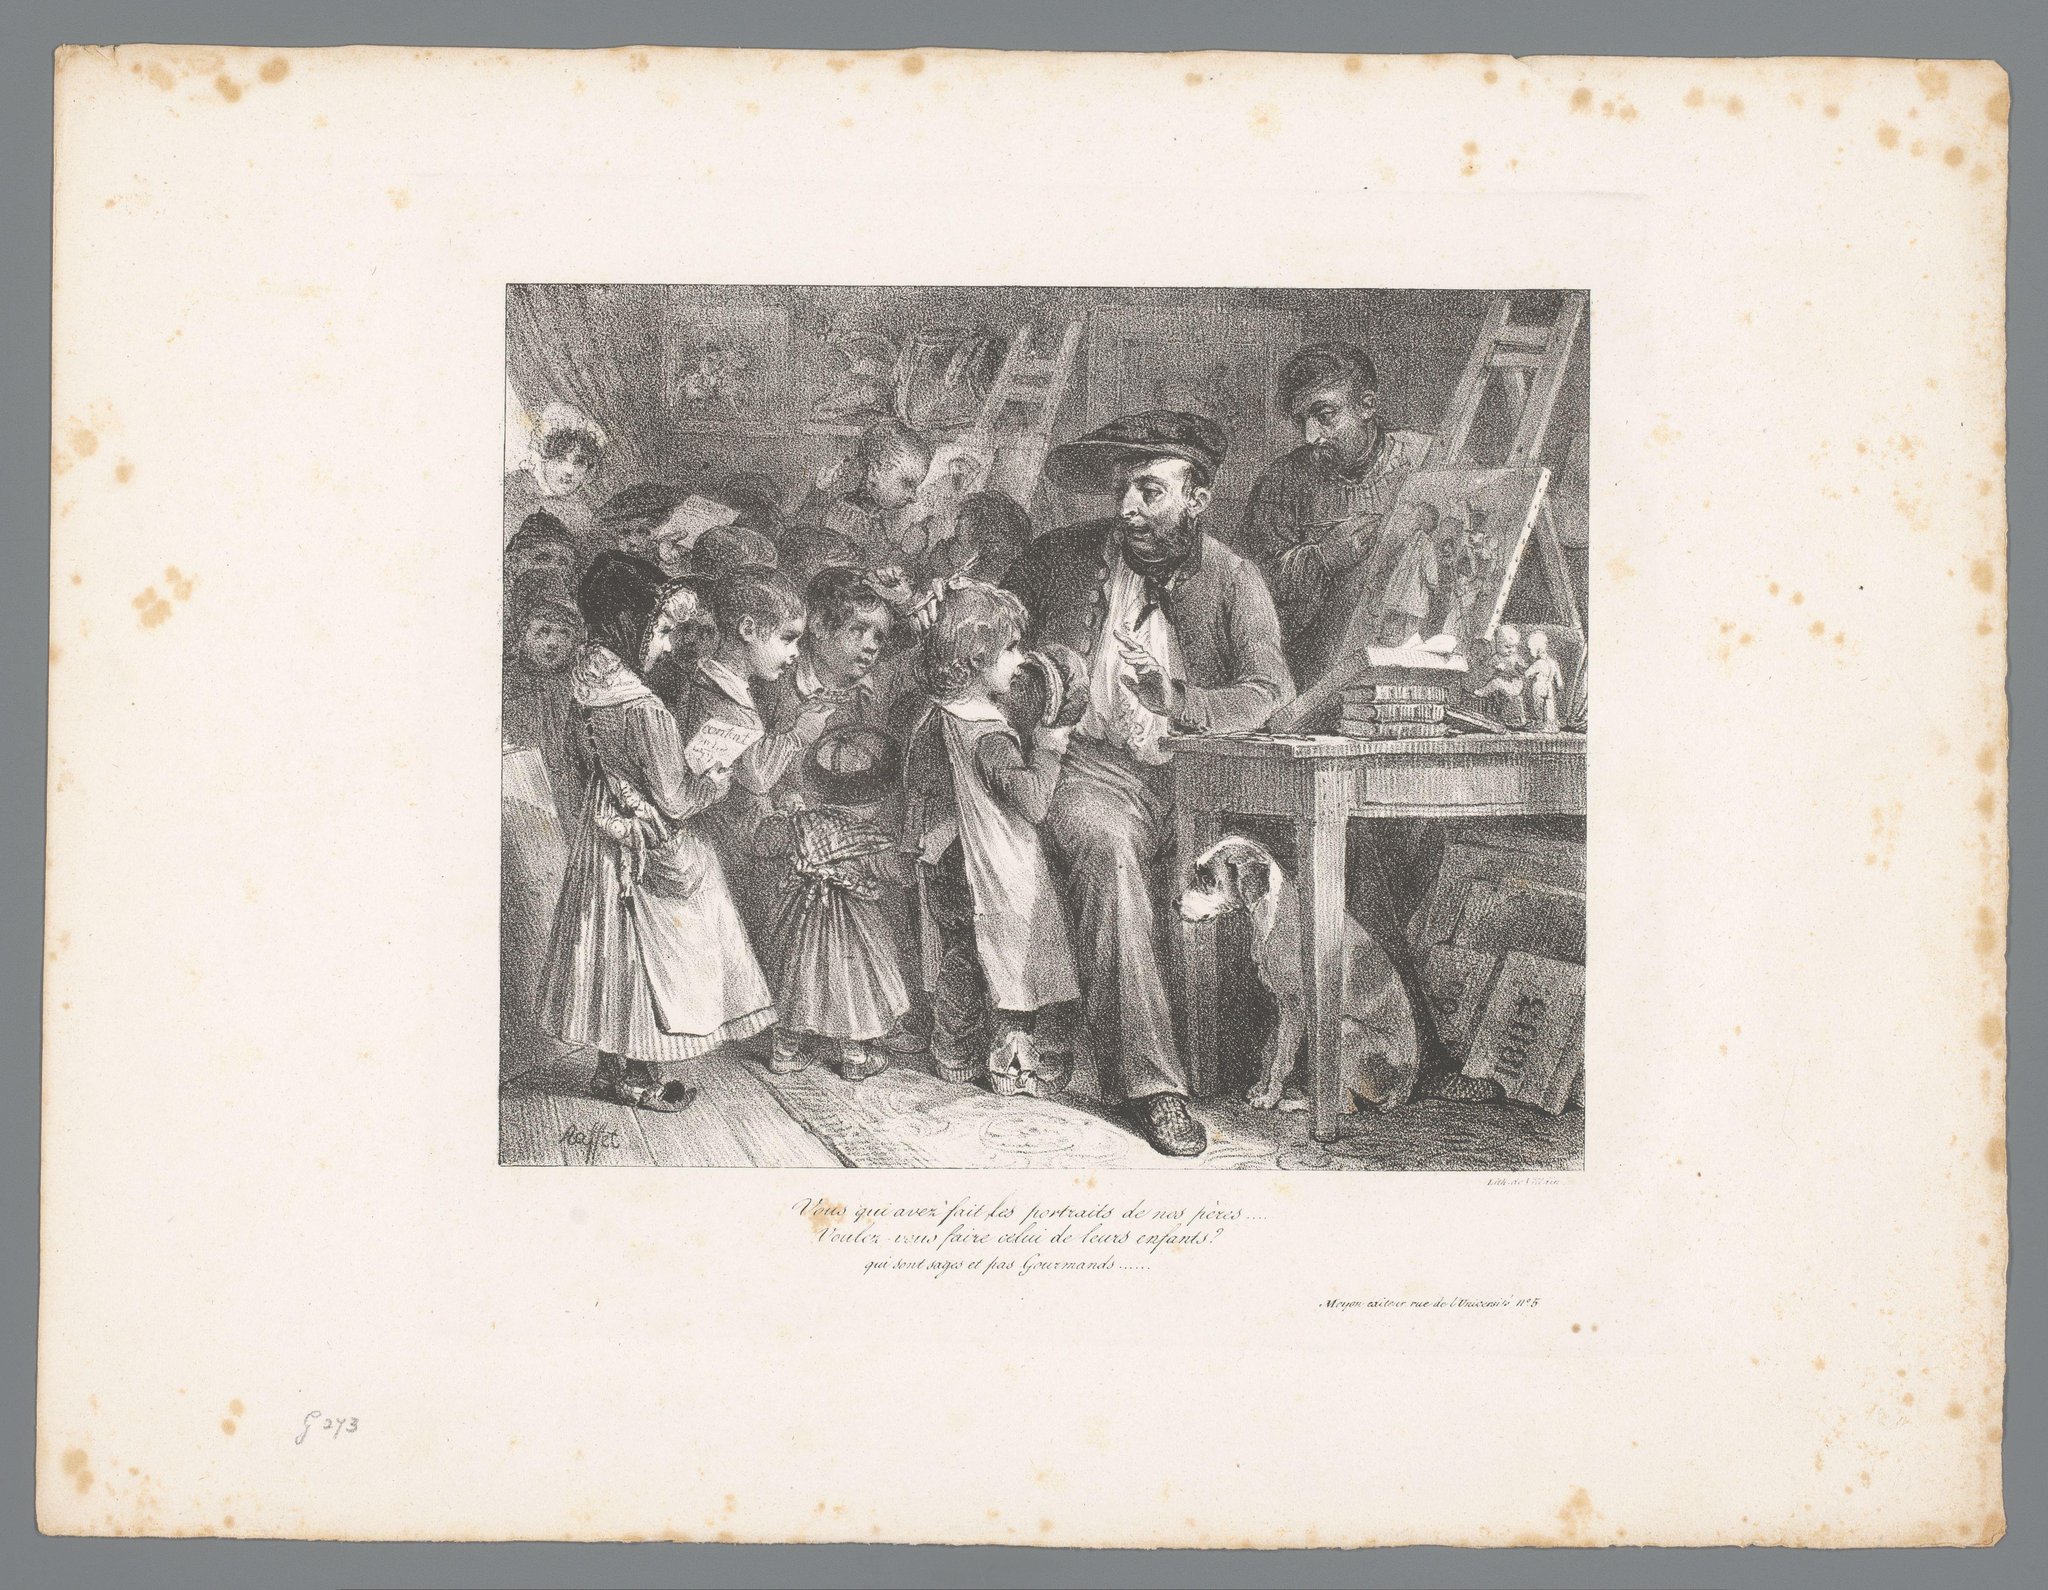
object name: print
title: Zittende schilder omringd door kinderen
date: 1827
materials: paper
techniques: lithograph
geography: paris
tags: child, workshop, studio ~ painter, picture, painting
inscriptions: collector's mark: Lugt 964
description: Serie bestaat uit titelprent en tien prenten. Tweede prent in de serie van elf prenten.